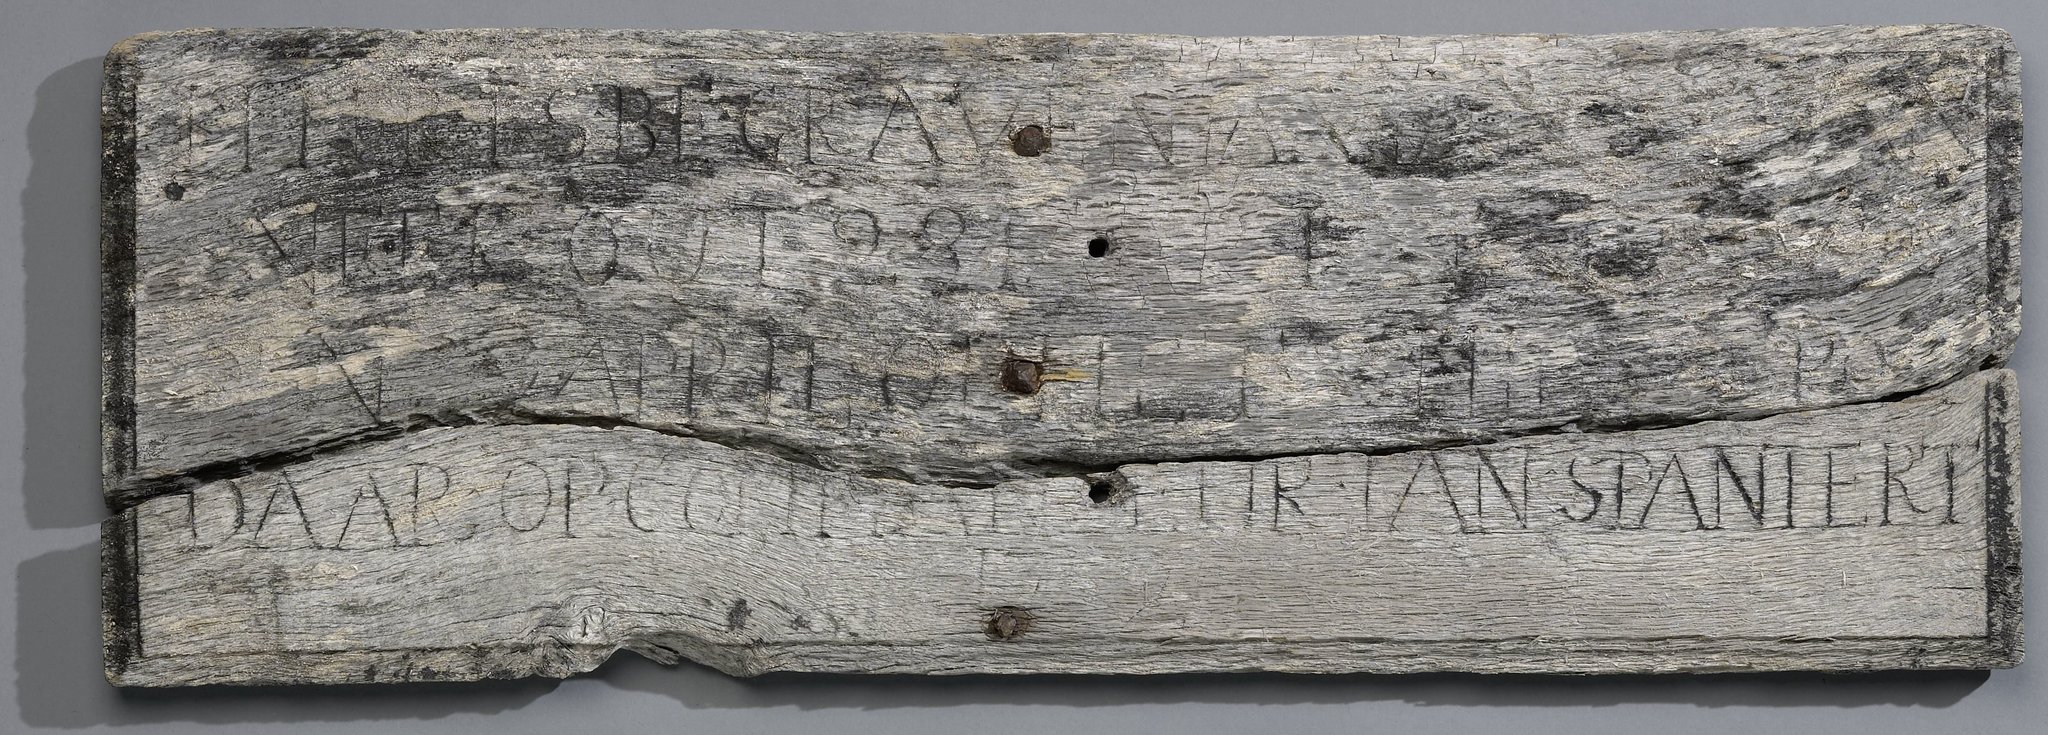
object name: grave cross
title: Houten grafbord (bovenste gedeelte) van een kruis afkomstig van het Nederlandse walvisverwerkingsstation Smeerenburg bij Spitsbergen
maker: Anonymous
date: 1725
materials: wood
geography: spitsbergen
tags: smeerenburg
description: Houten rechthoekige plank over de hele lengte gespleten in tweeën met ingekerfd de gegevens van een overleden zeeman. Dit is het bovenste gedeelte. In 1978 door J.B. Kist gevonden ten NO van Smeerenburg. Het opschrift is slecht leesbaar: HIER IS BEGRAVEN ... / ... OUT 28 JARE ... / ... VARENDE OP HET ...(SCHIP) / DAAR OP COMMANDEUR IAN SPANIERT.